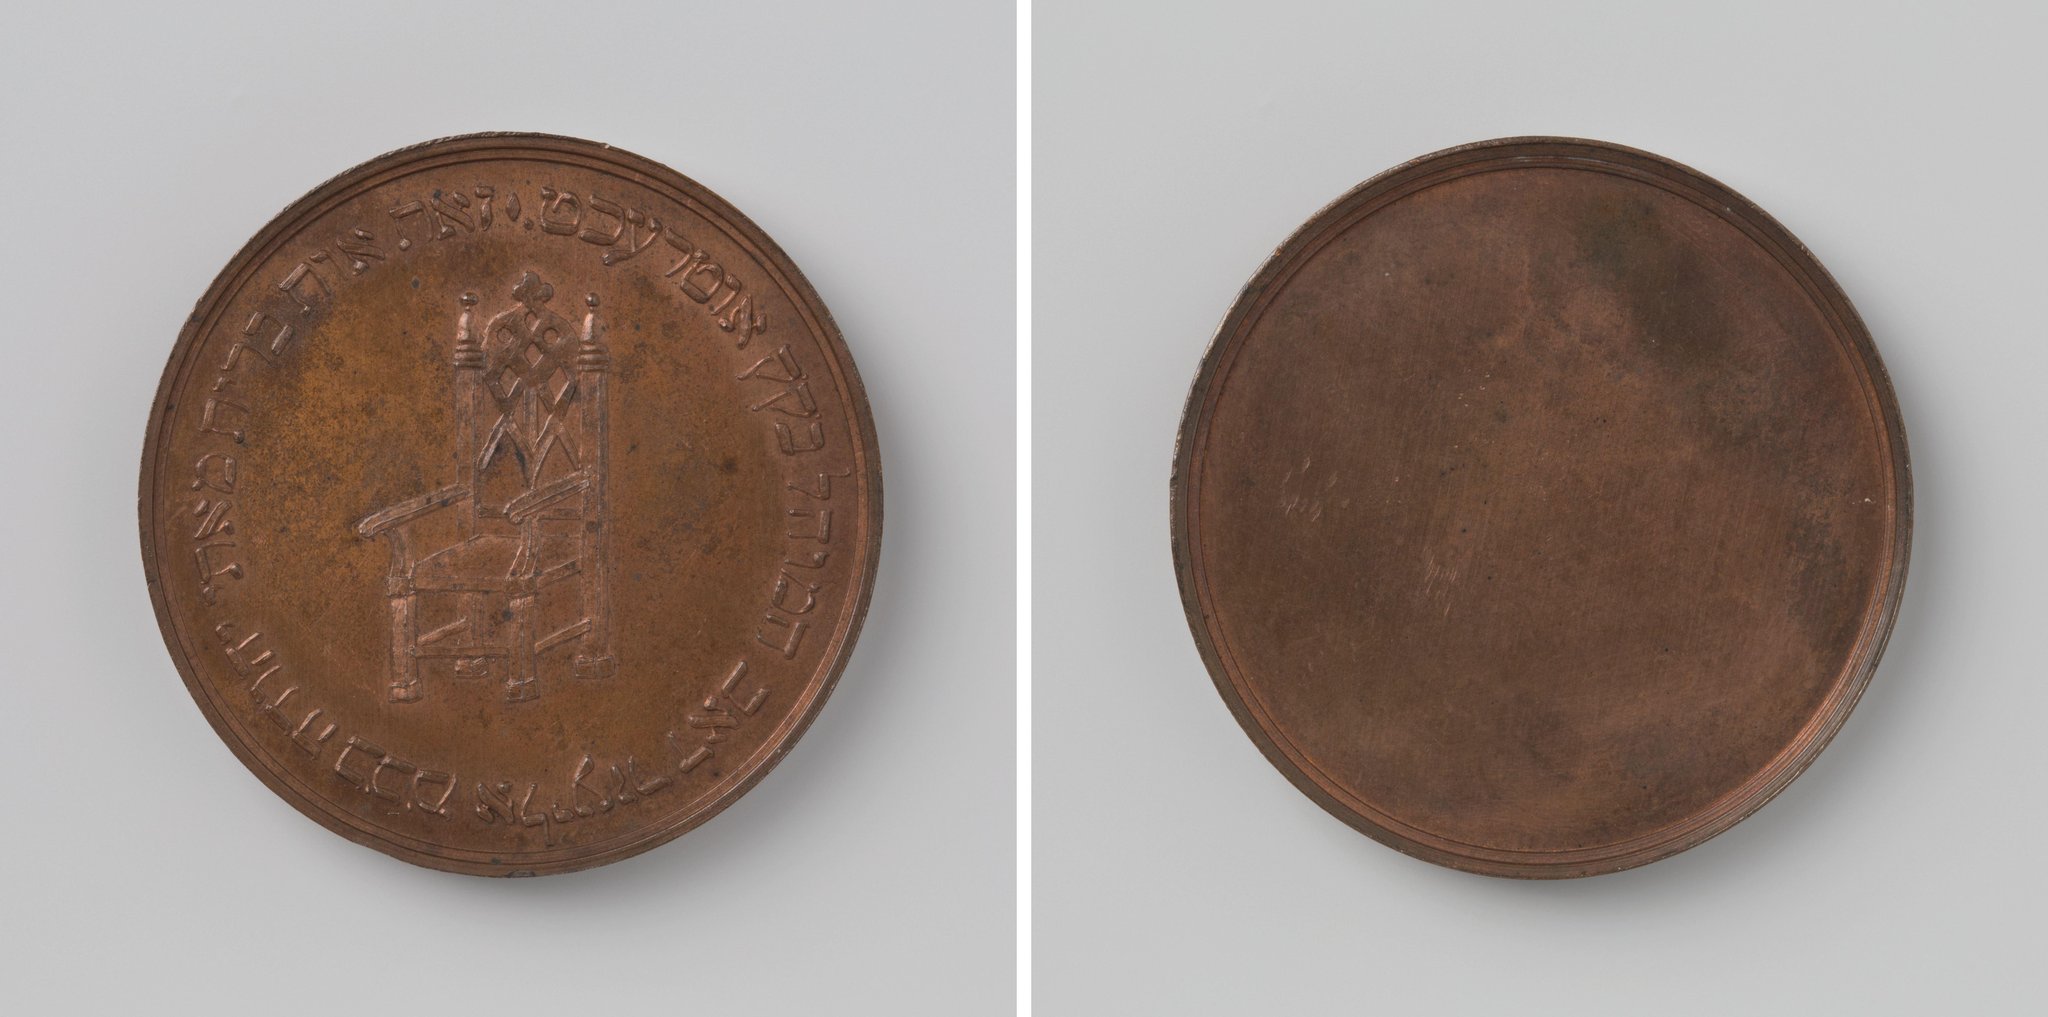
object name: family medal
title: Besnijdenis, penning aan besneden jonge Israelieten vereerd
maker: l.j. de beer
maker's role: die cutter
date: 1842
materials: bronze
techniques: striking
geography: utrecht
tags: utrecht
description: Eenzijdige bronzen penning. Voorzijde: zetel binnen omschrift in Hebreeuws schrift. Keerzijde: blanco.